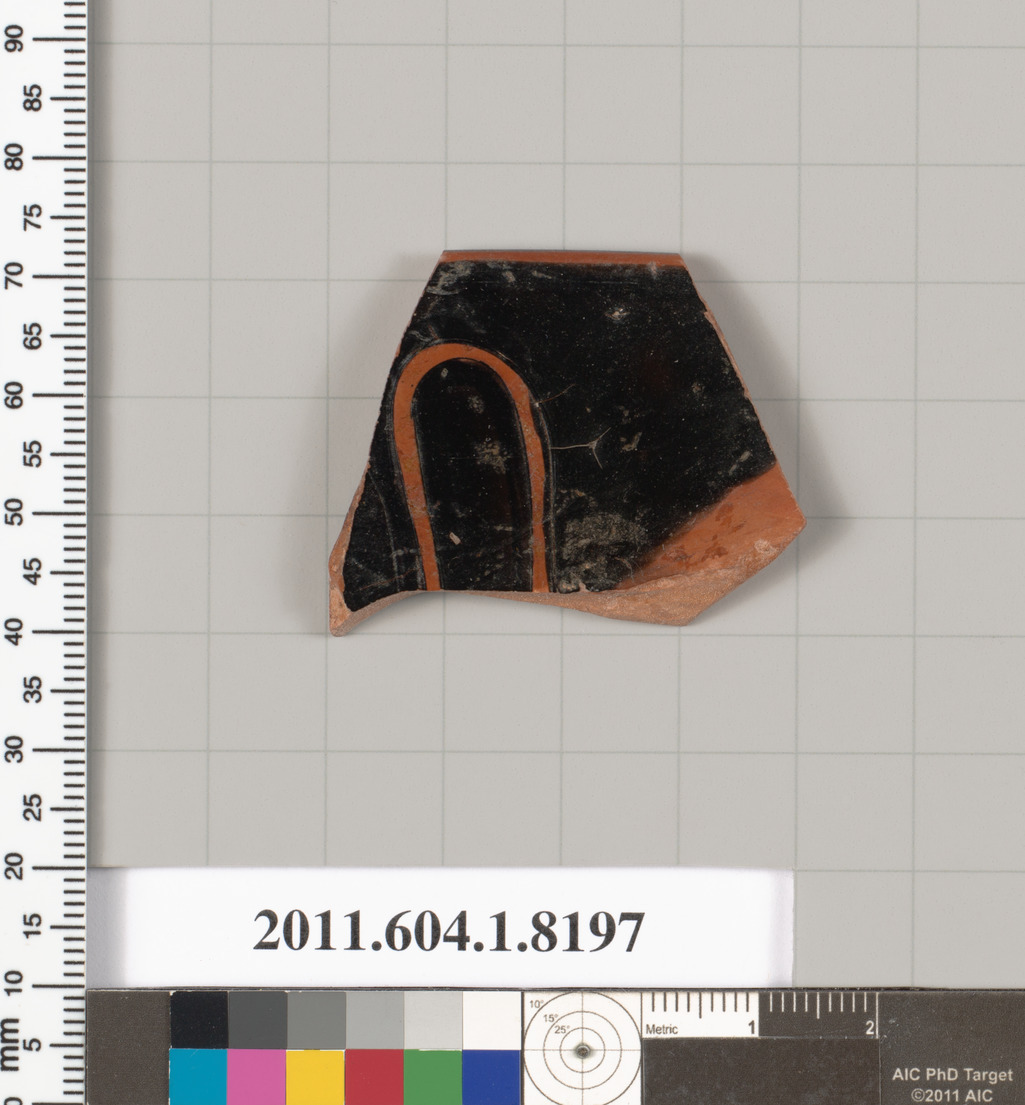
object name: kylix fragment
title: Terracotta rim fragment of a kylix (drinking cup)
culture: greek, attic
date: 534-468 BCE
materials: terracotta